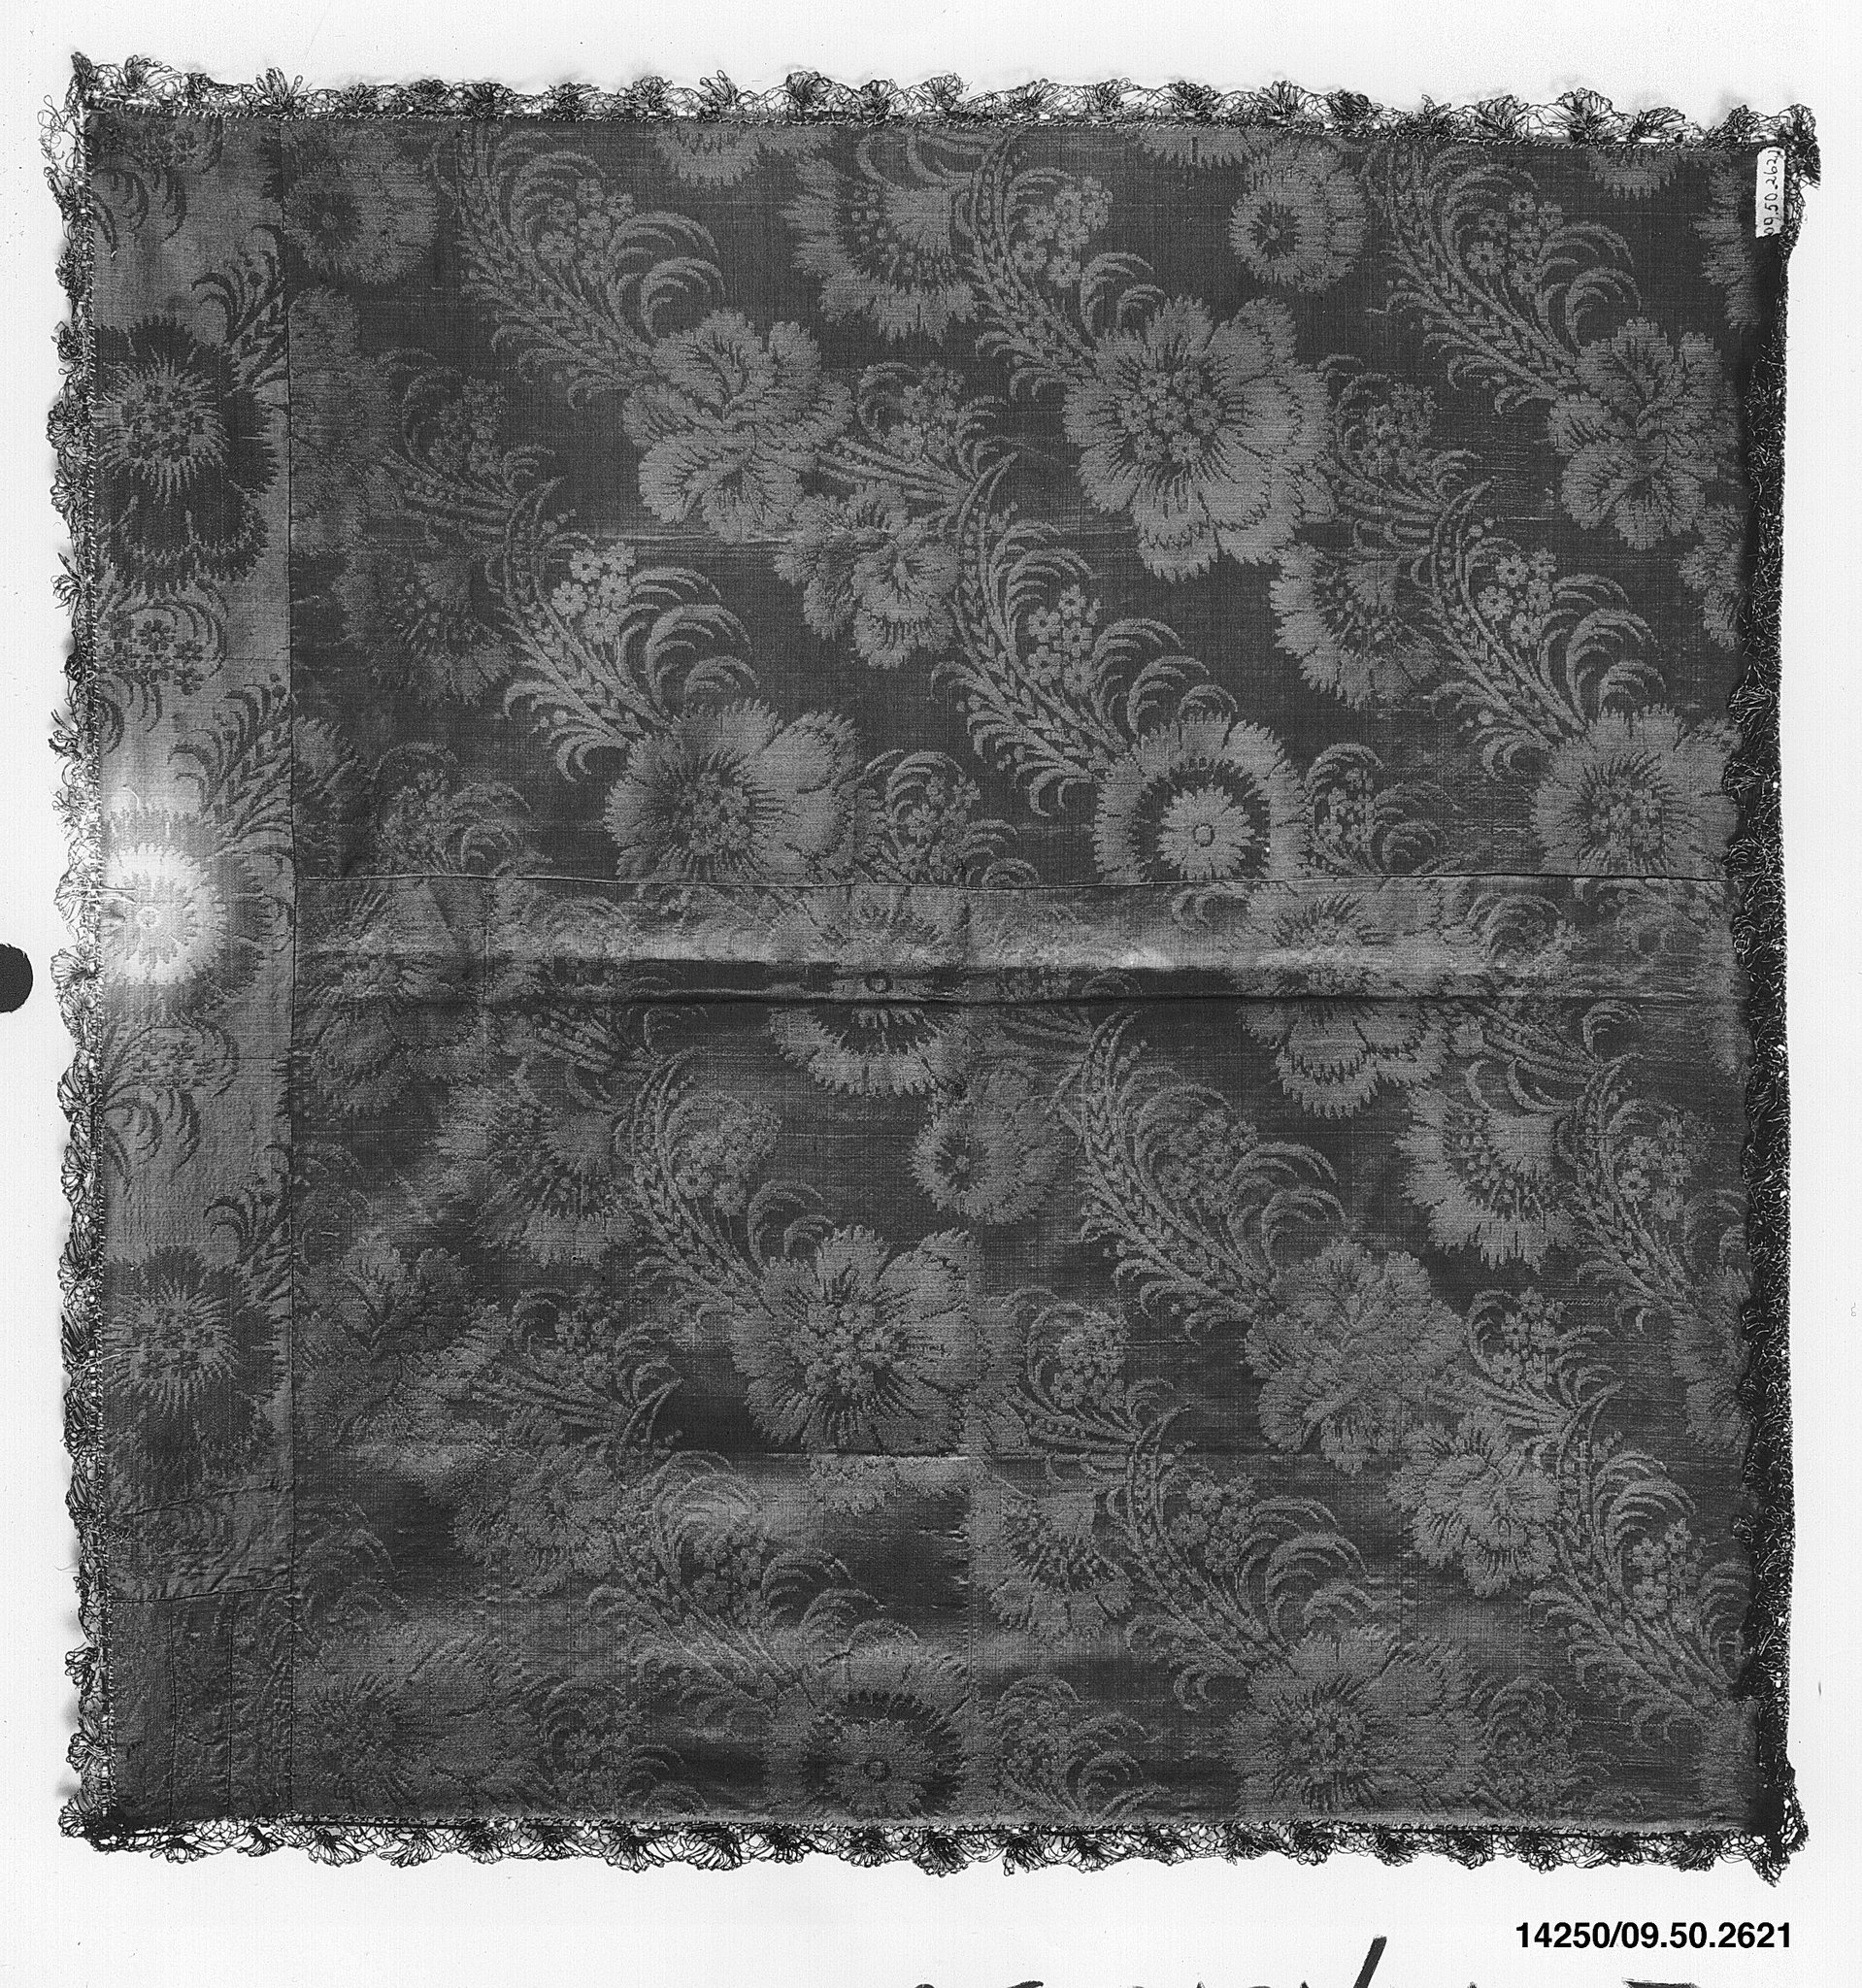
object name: piece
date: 1730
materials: silk